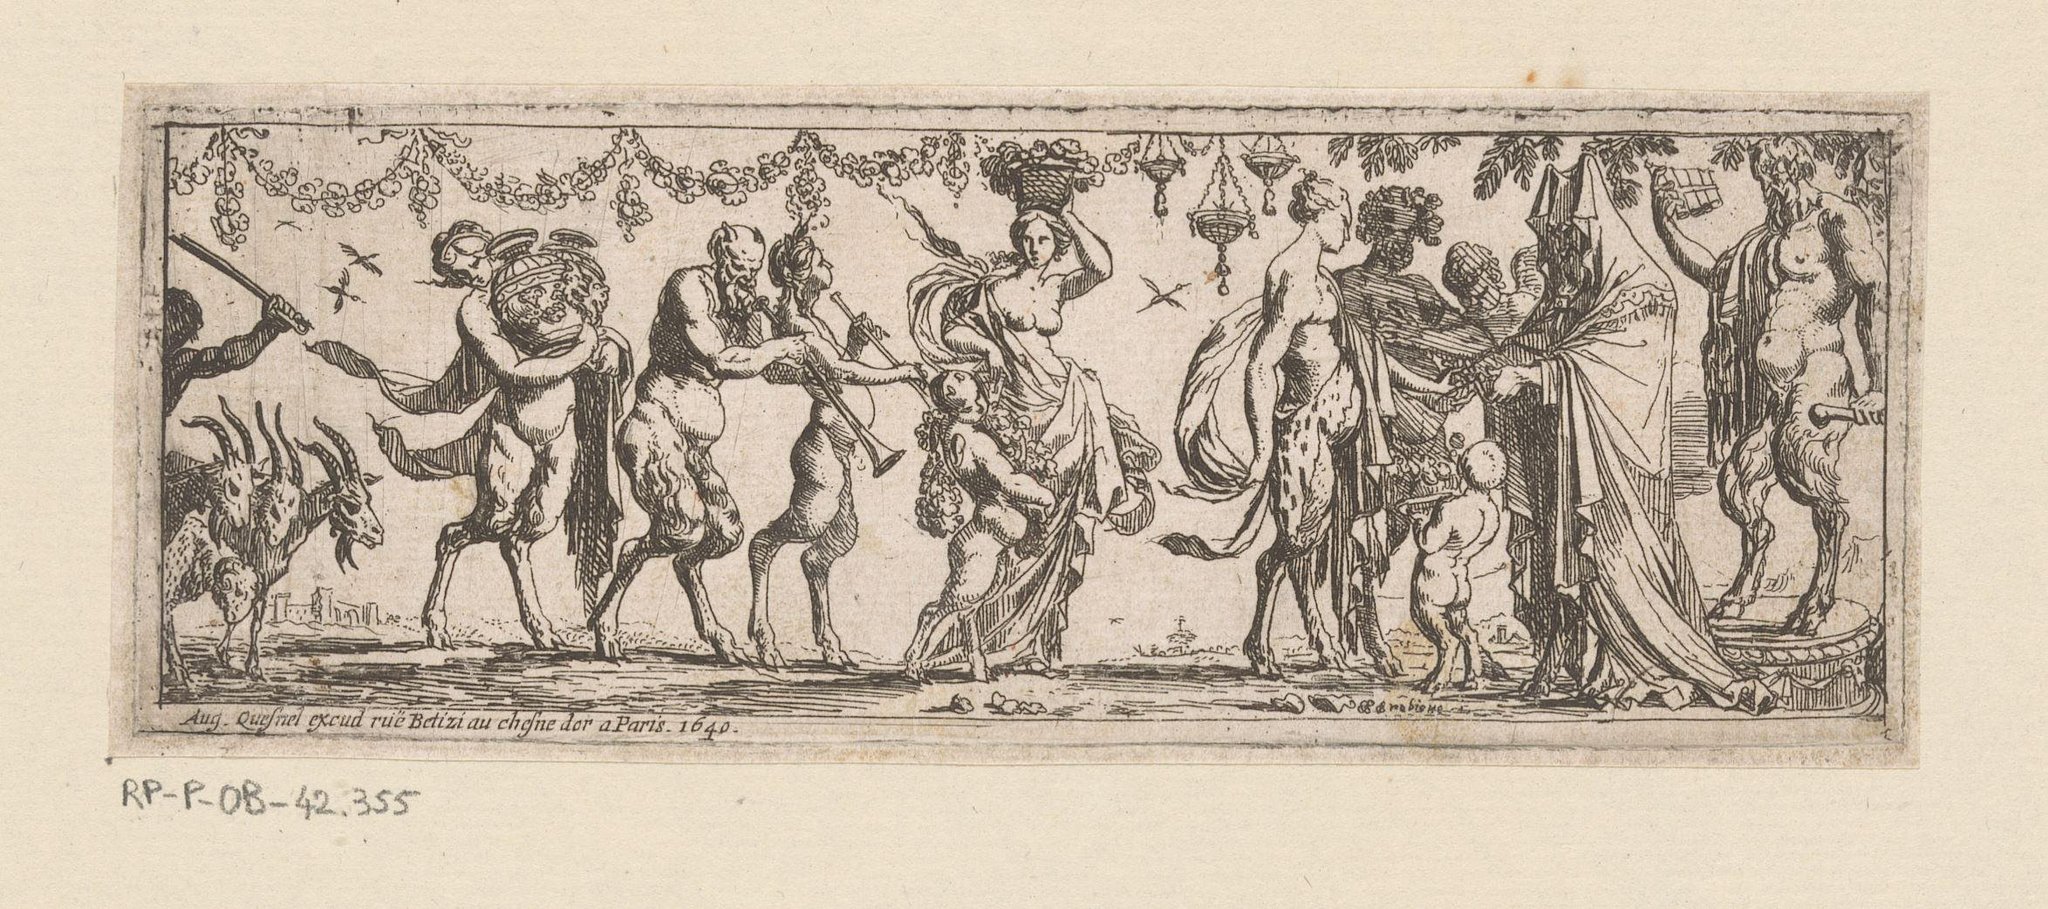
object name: print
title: Huwelijk van een sater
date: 1608-1650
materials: paper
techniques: etching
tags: satyr(s) (in general), (civil) marriage ceremonies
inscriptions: collector's mark: Lugt 240